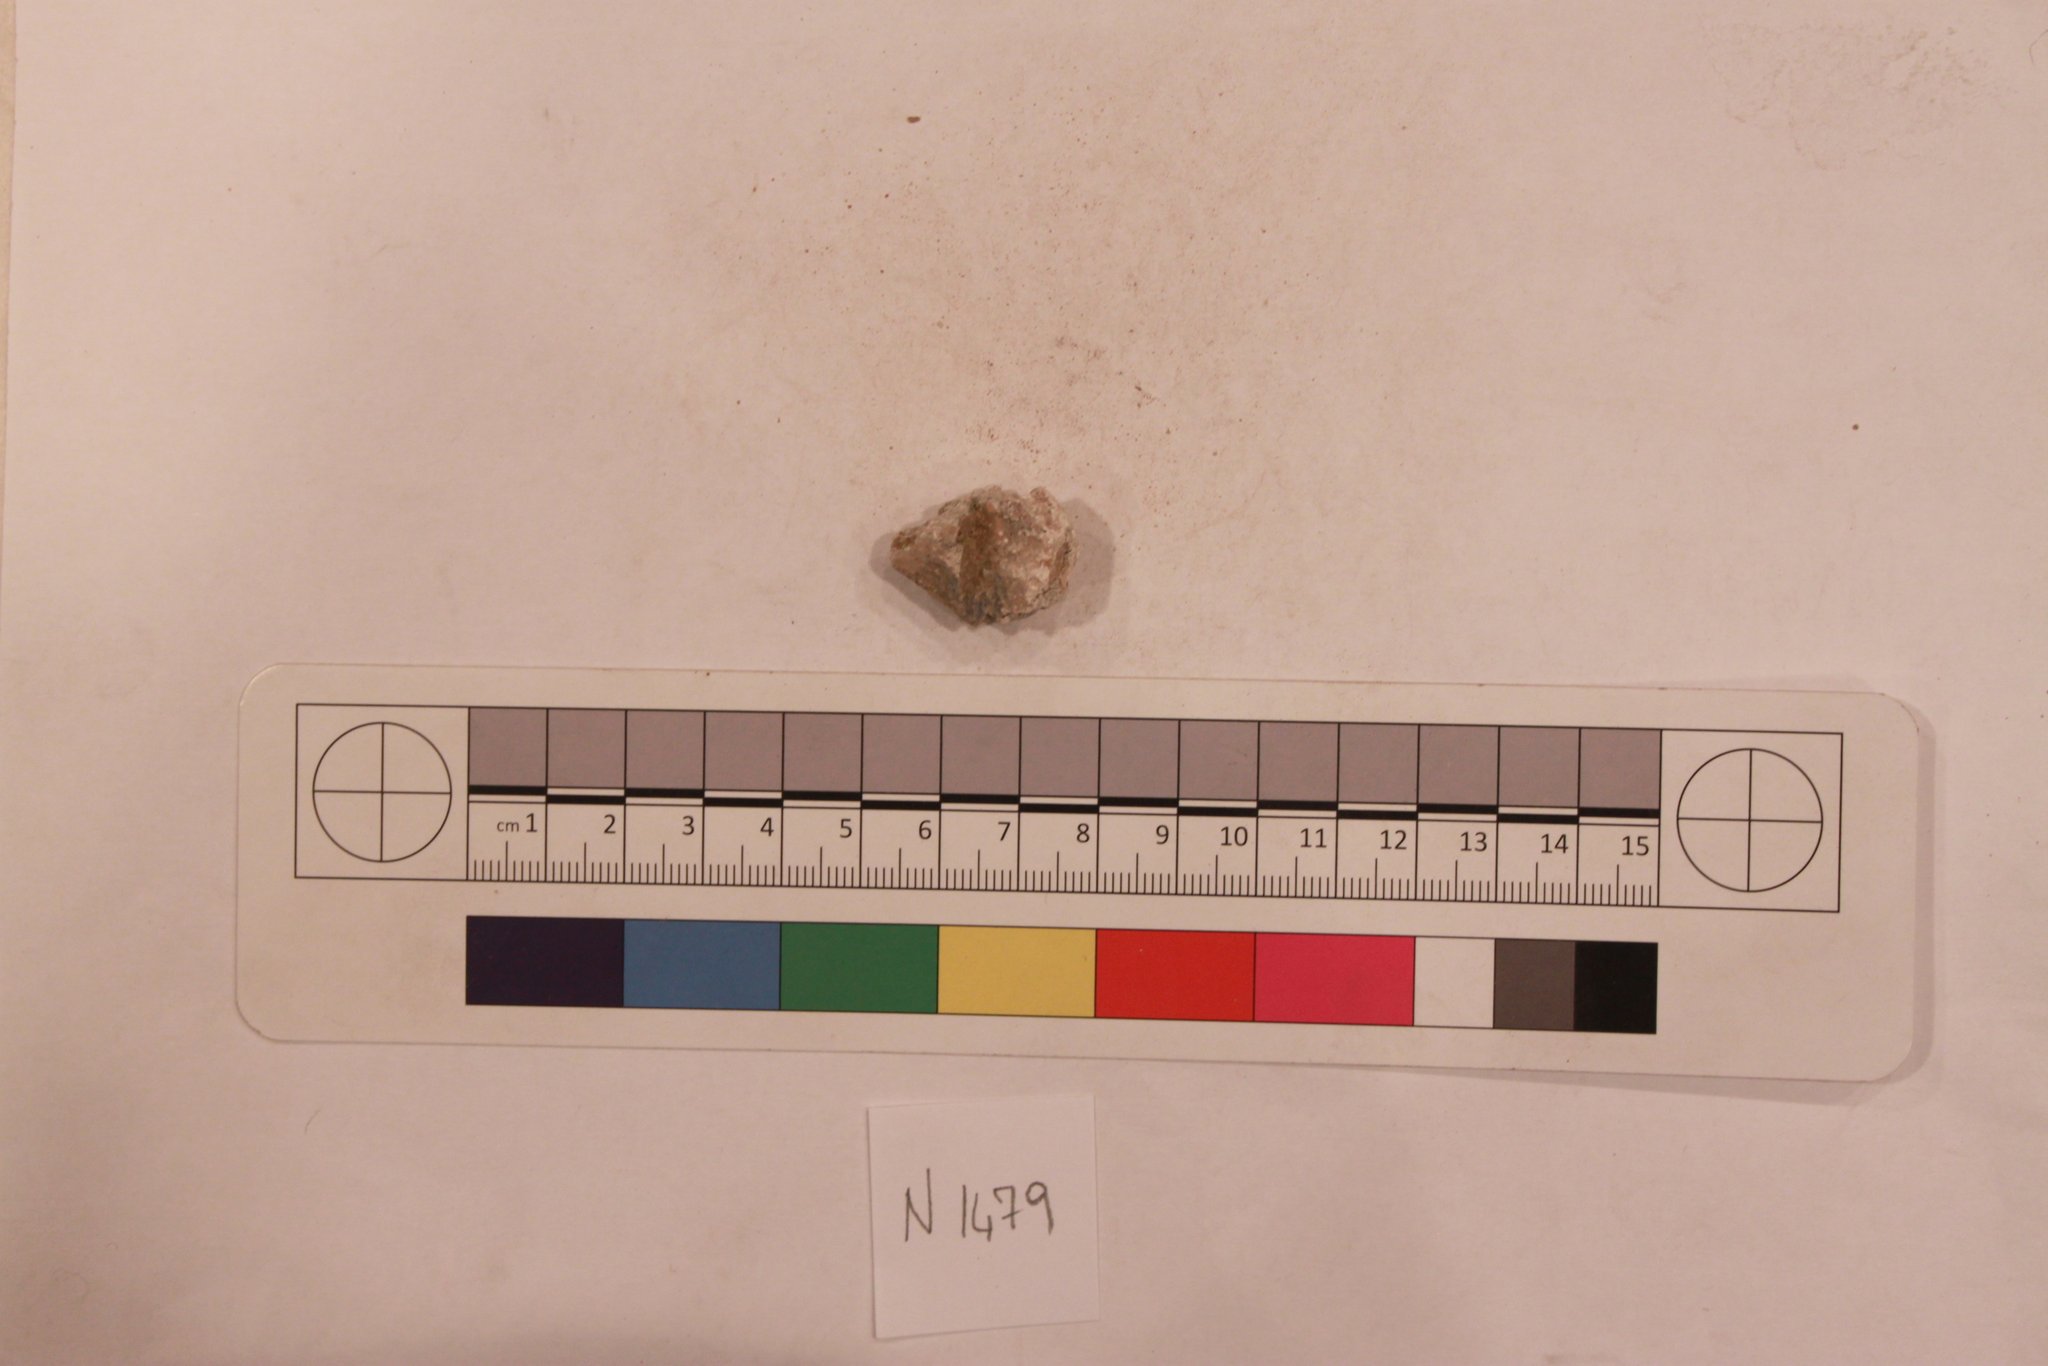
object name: fragment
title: Stucco Fragment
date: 701-1200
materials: plaster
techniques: carving, painting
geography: iran